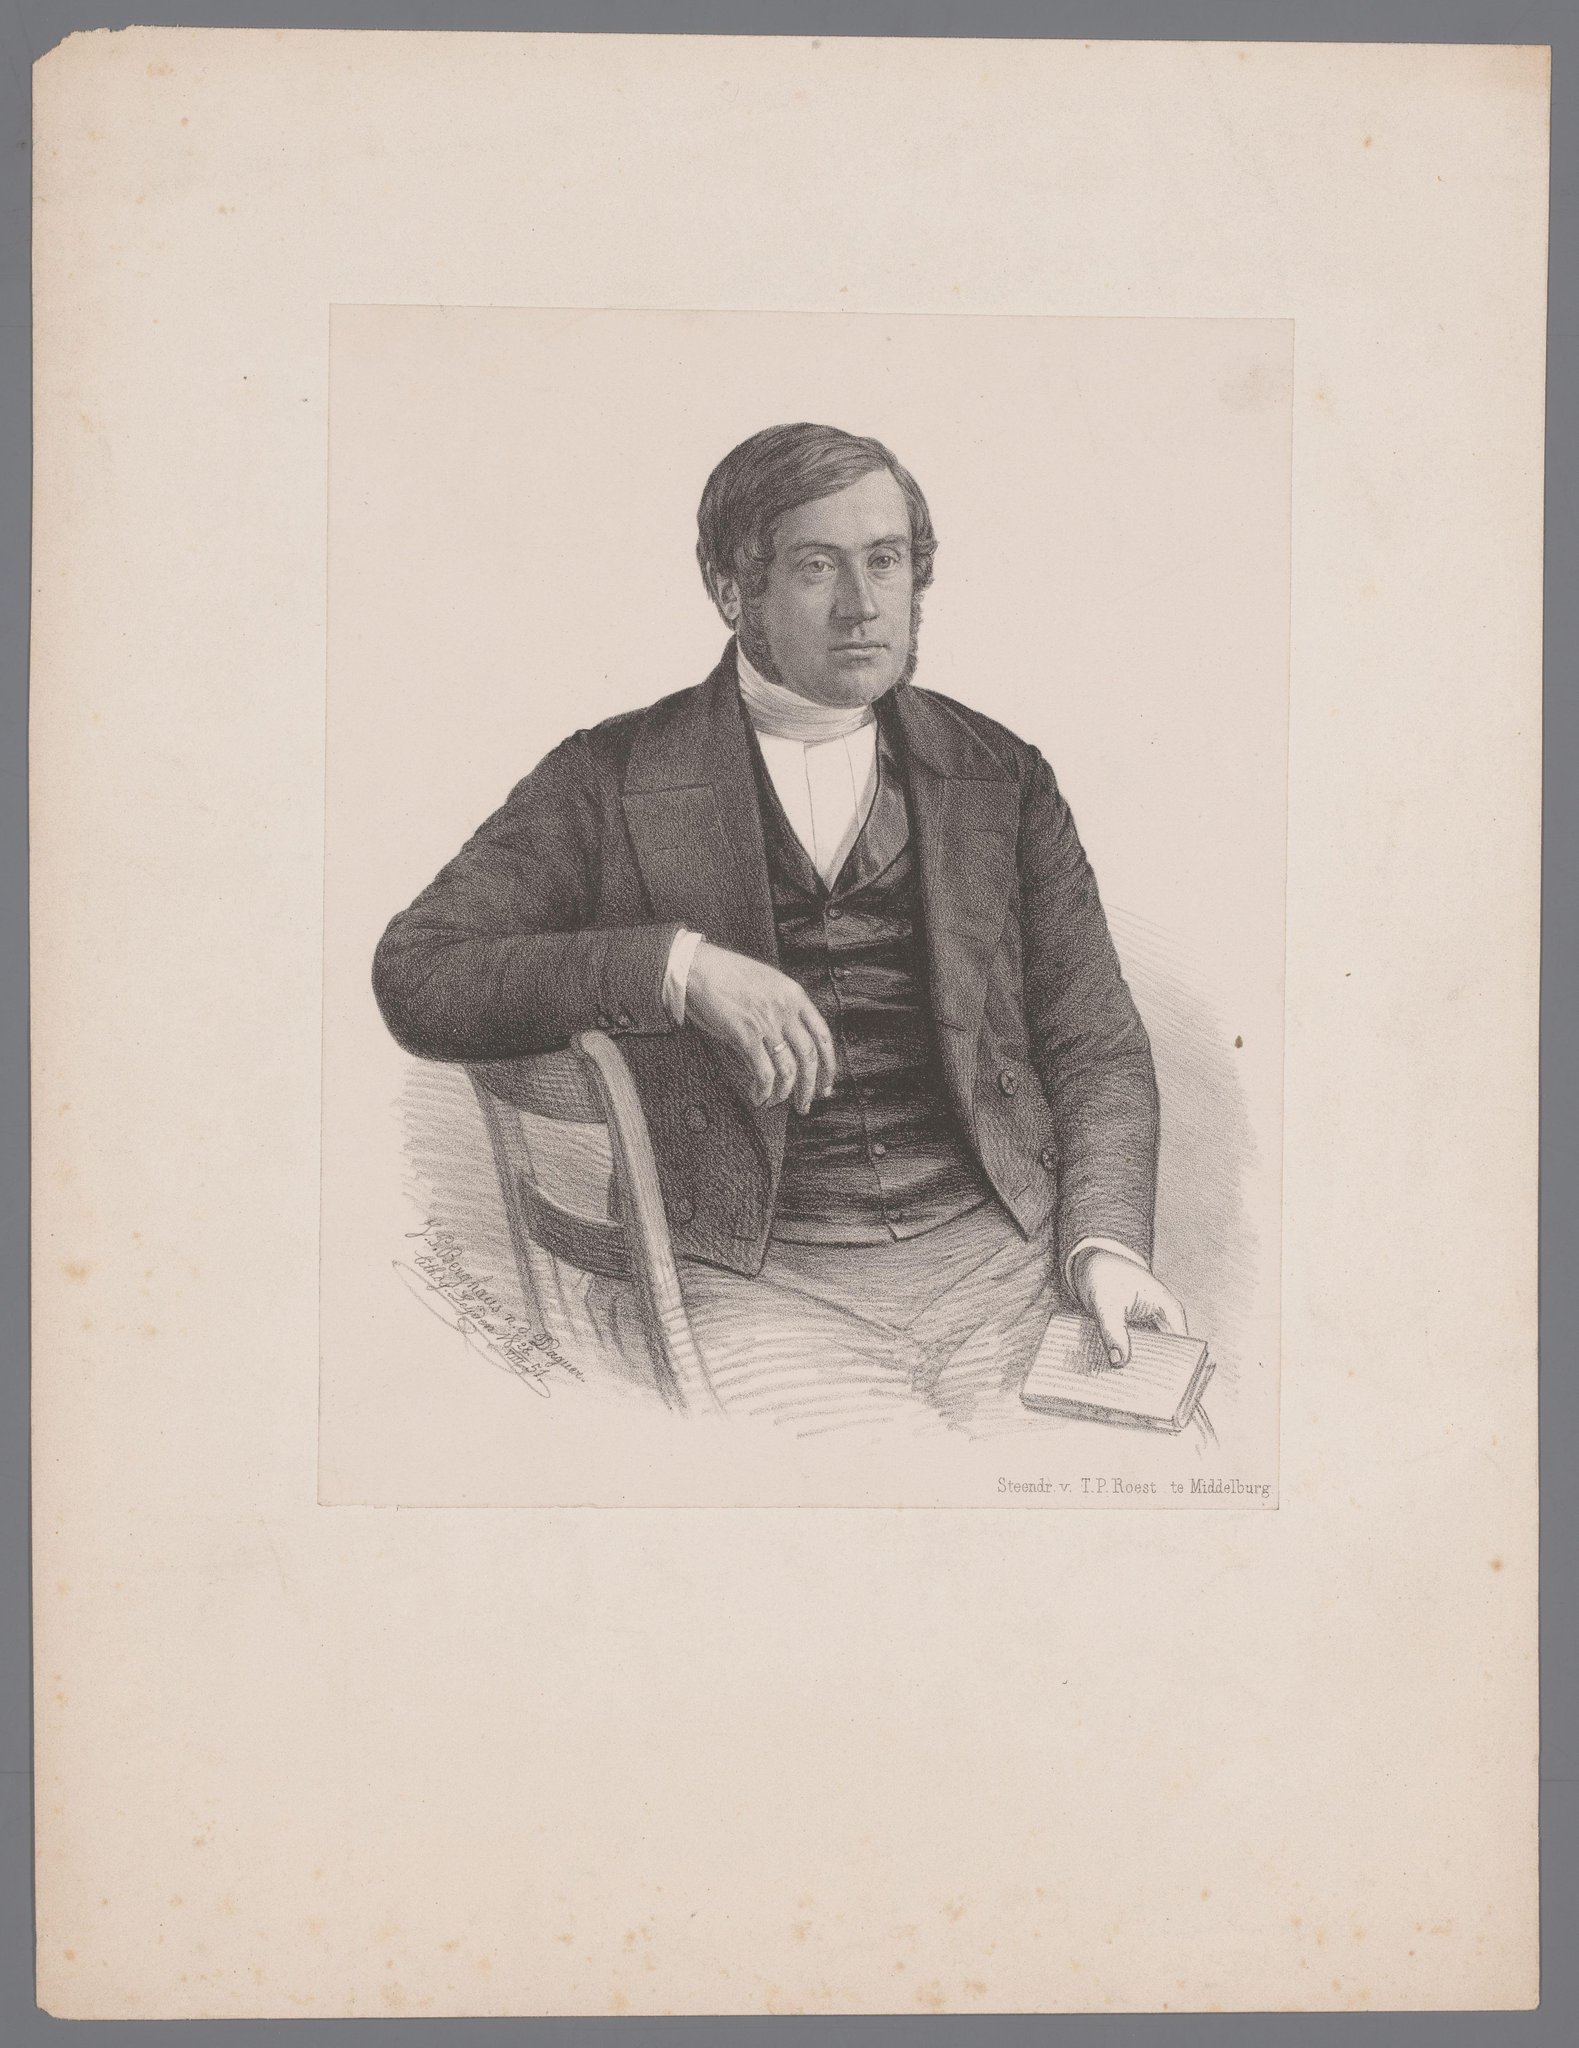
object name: print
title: Portret van Johannes Petrus Hasebroek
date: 1851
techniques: lithograph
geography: middelburg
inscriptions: date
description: De geportretteerde zit gedraaid op een stoel en steunt met zijn rechterarm op de rugleuning. Zijn linkerhand, met daarin een boek, rust op zijn bovenbeen.